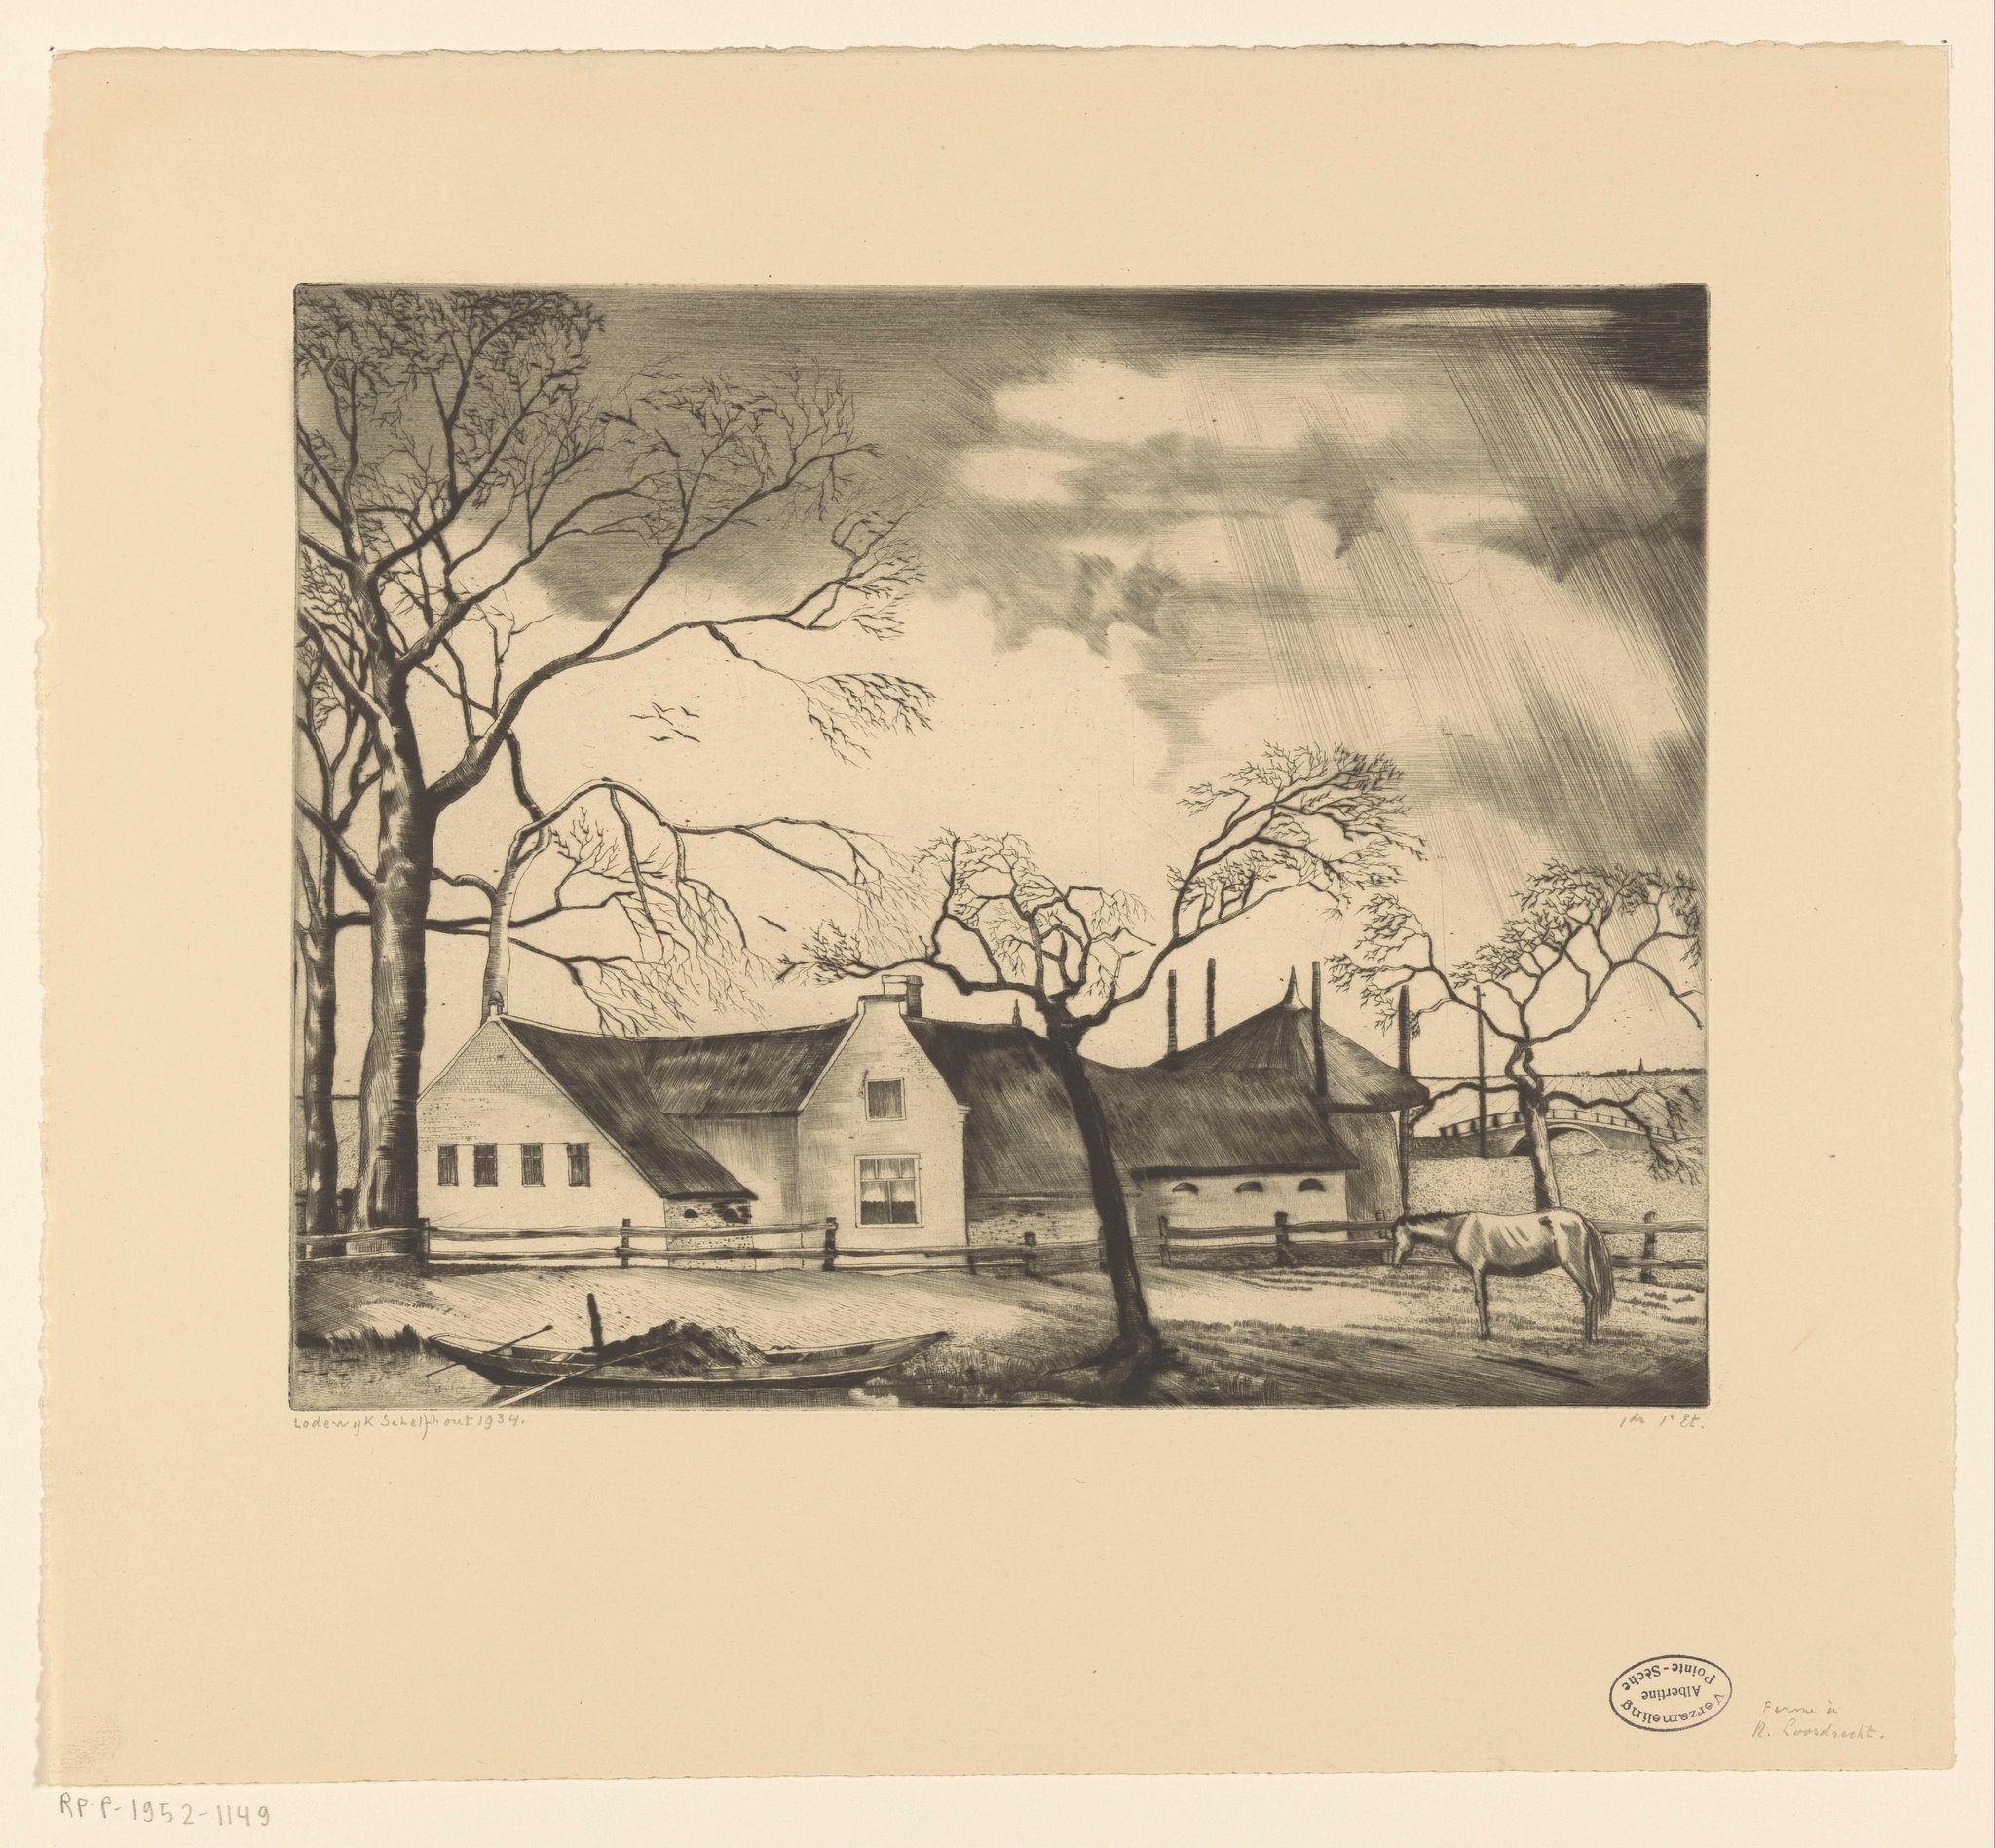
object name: print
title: Boerderij met hooischuur in Nieuw-Loosdrecht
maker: lodewijk schelfhout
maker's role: draughtsman, print maker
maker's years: 1881-1943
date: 1934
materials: paper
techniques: drypoint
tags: trees (+ bare plant), horse, farm or solitary house in landscape, nieuw-loosdrecht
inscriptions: collector's mark: Lugt 5i, collector's mark: Lugt 2228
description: Op de voorgrond een schuit in een vaart, bomen met kale takken en een paard in een weiland. Rechts op de achtergrond een brug en het silhouet van een nederzetting met kerk.